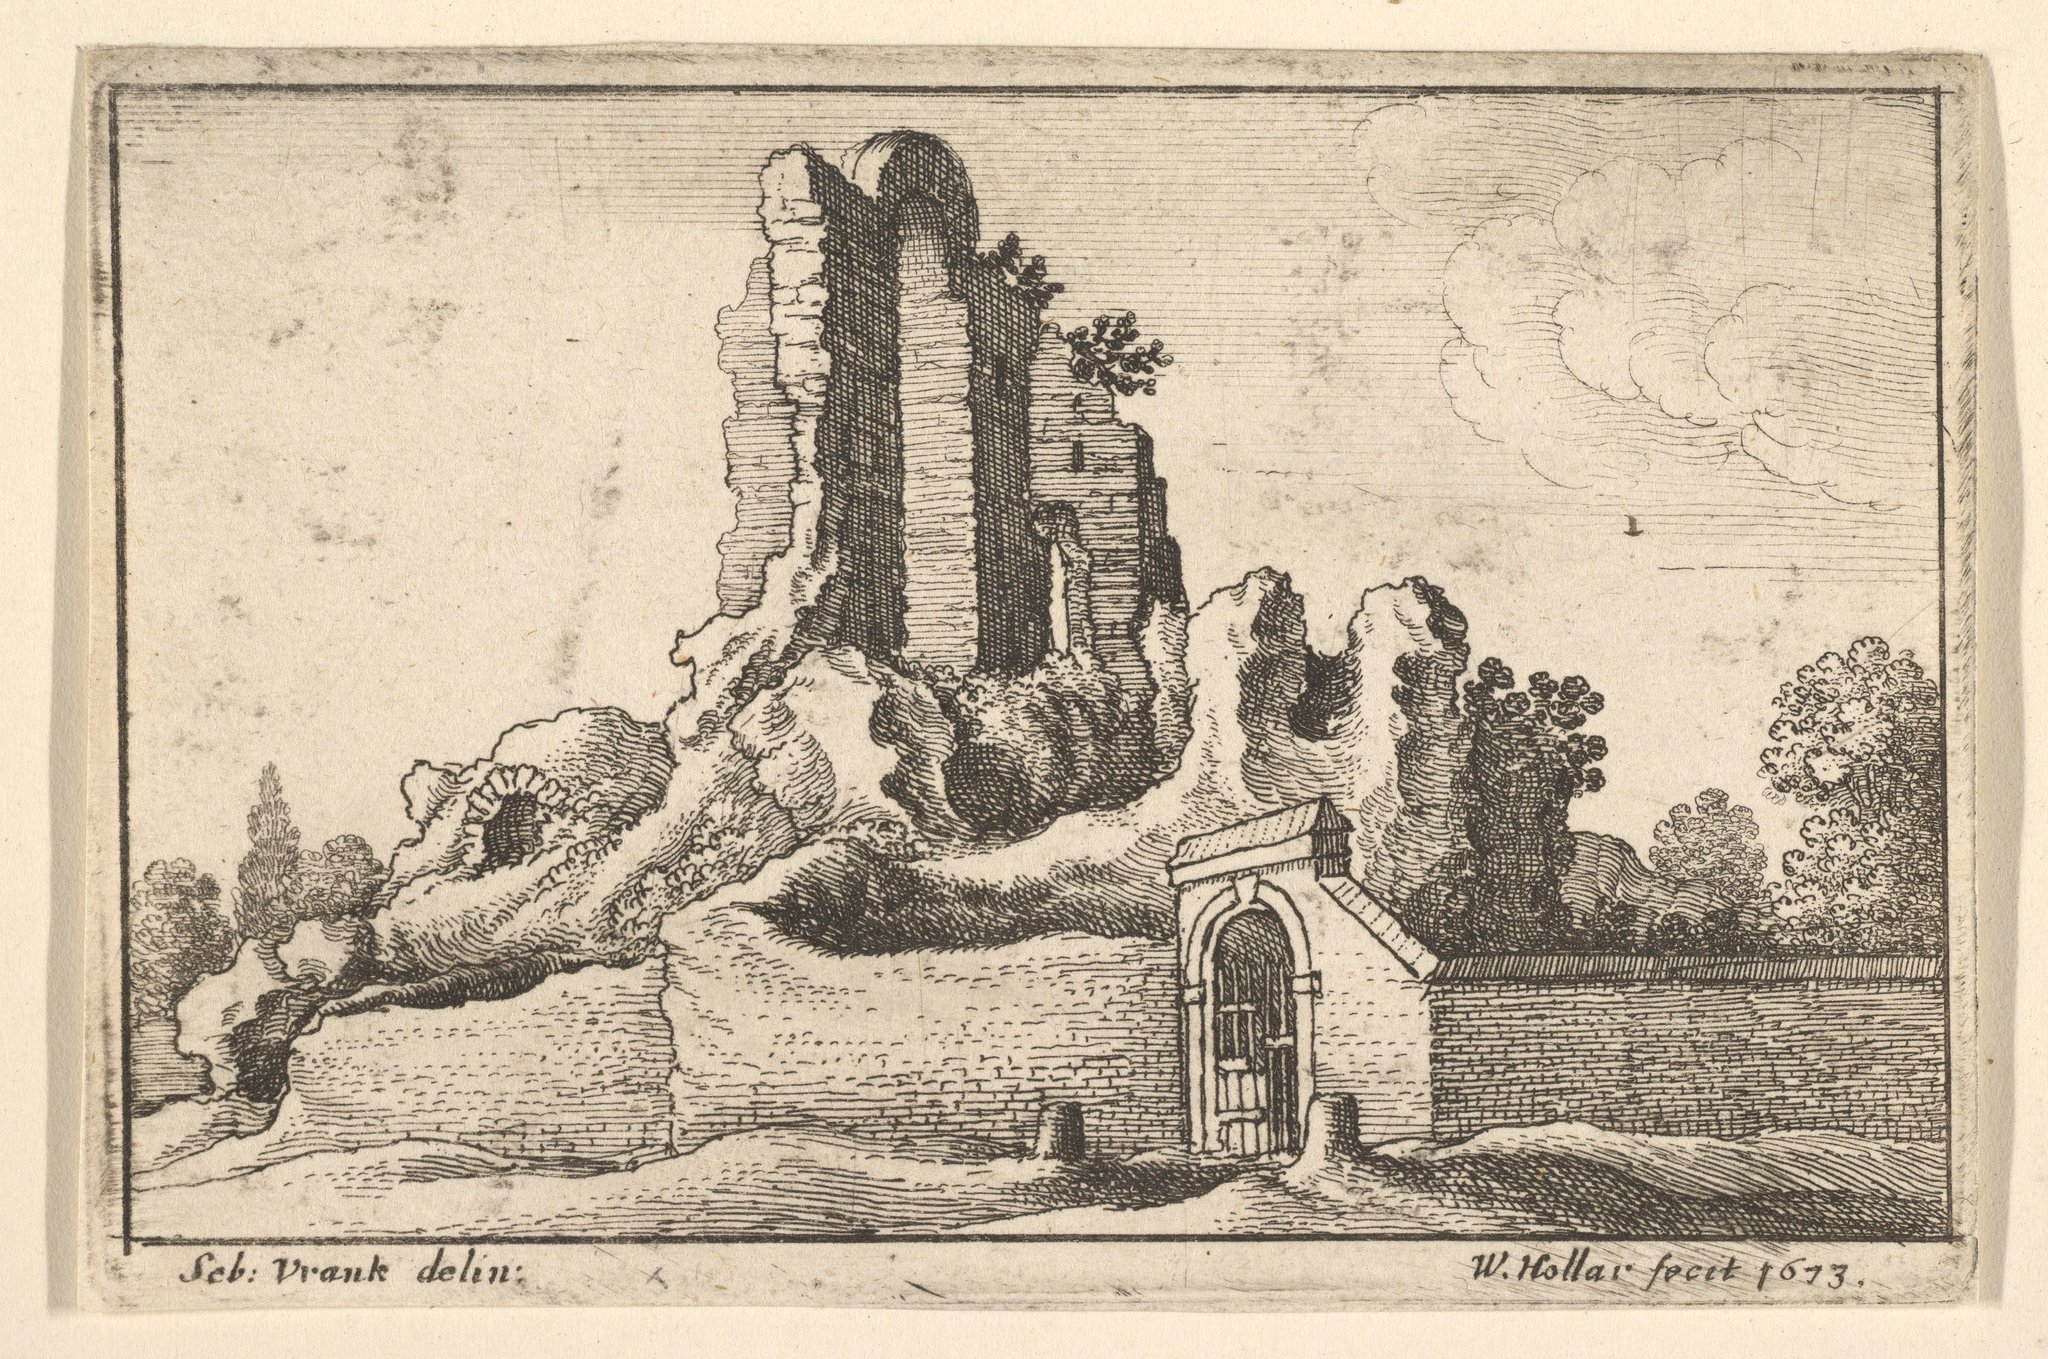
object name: print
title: Ruins and a barred gate on the Esquiline Hill in Rome, from "Roman Ruins"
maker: wenceslaus hollar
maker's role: artist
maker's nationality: bohemian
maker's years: 1607-1677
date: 1673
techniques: etching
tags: gates,ruins